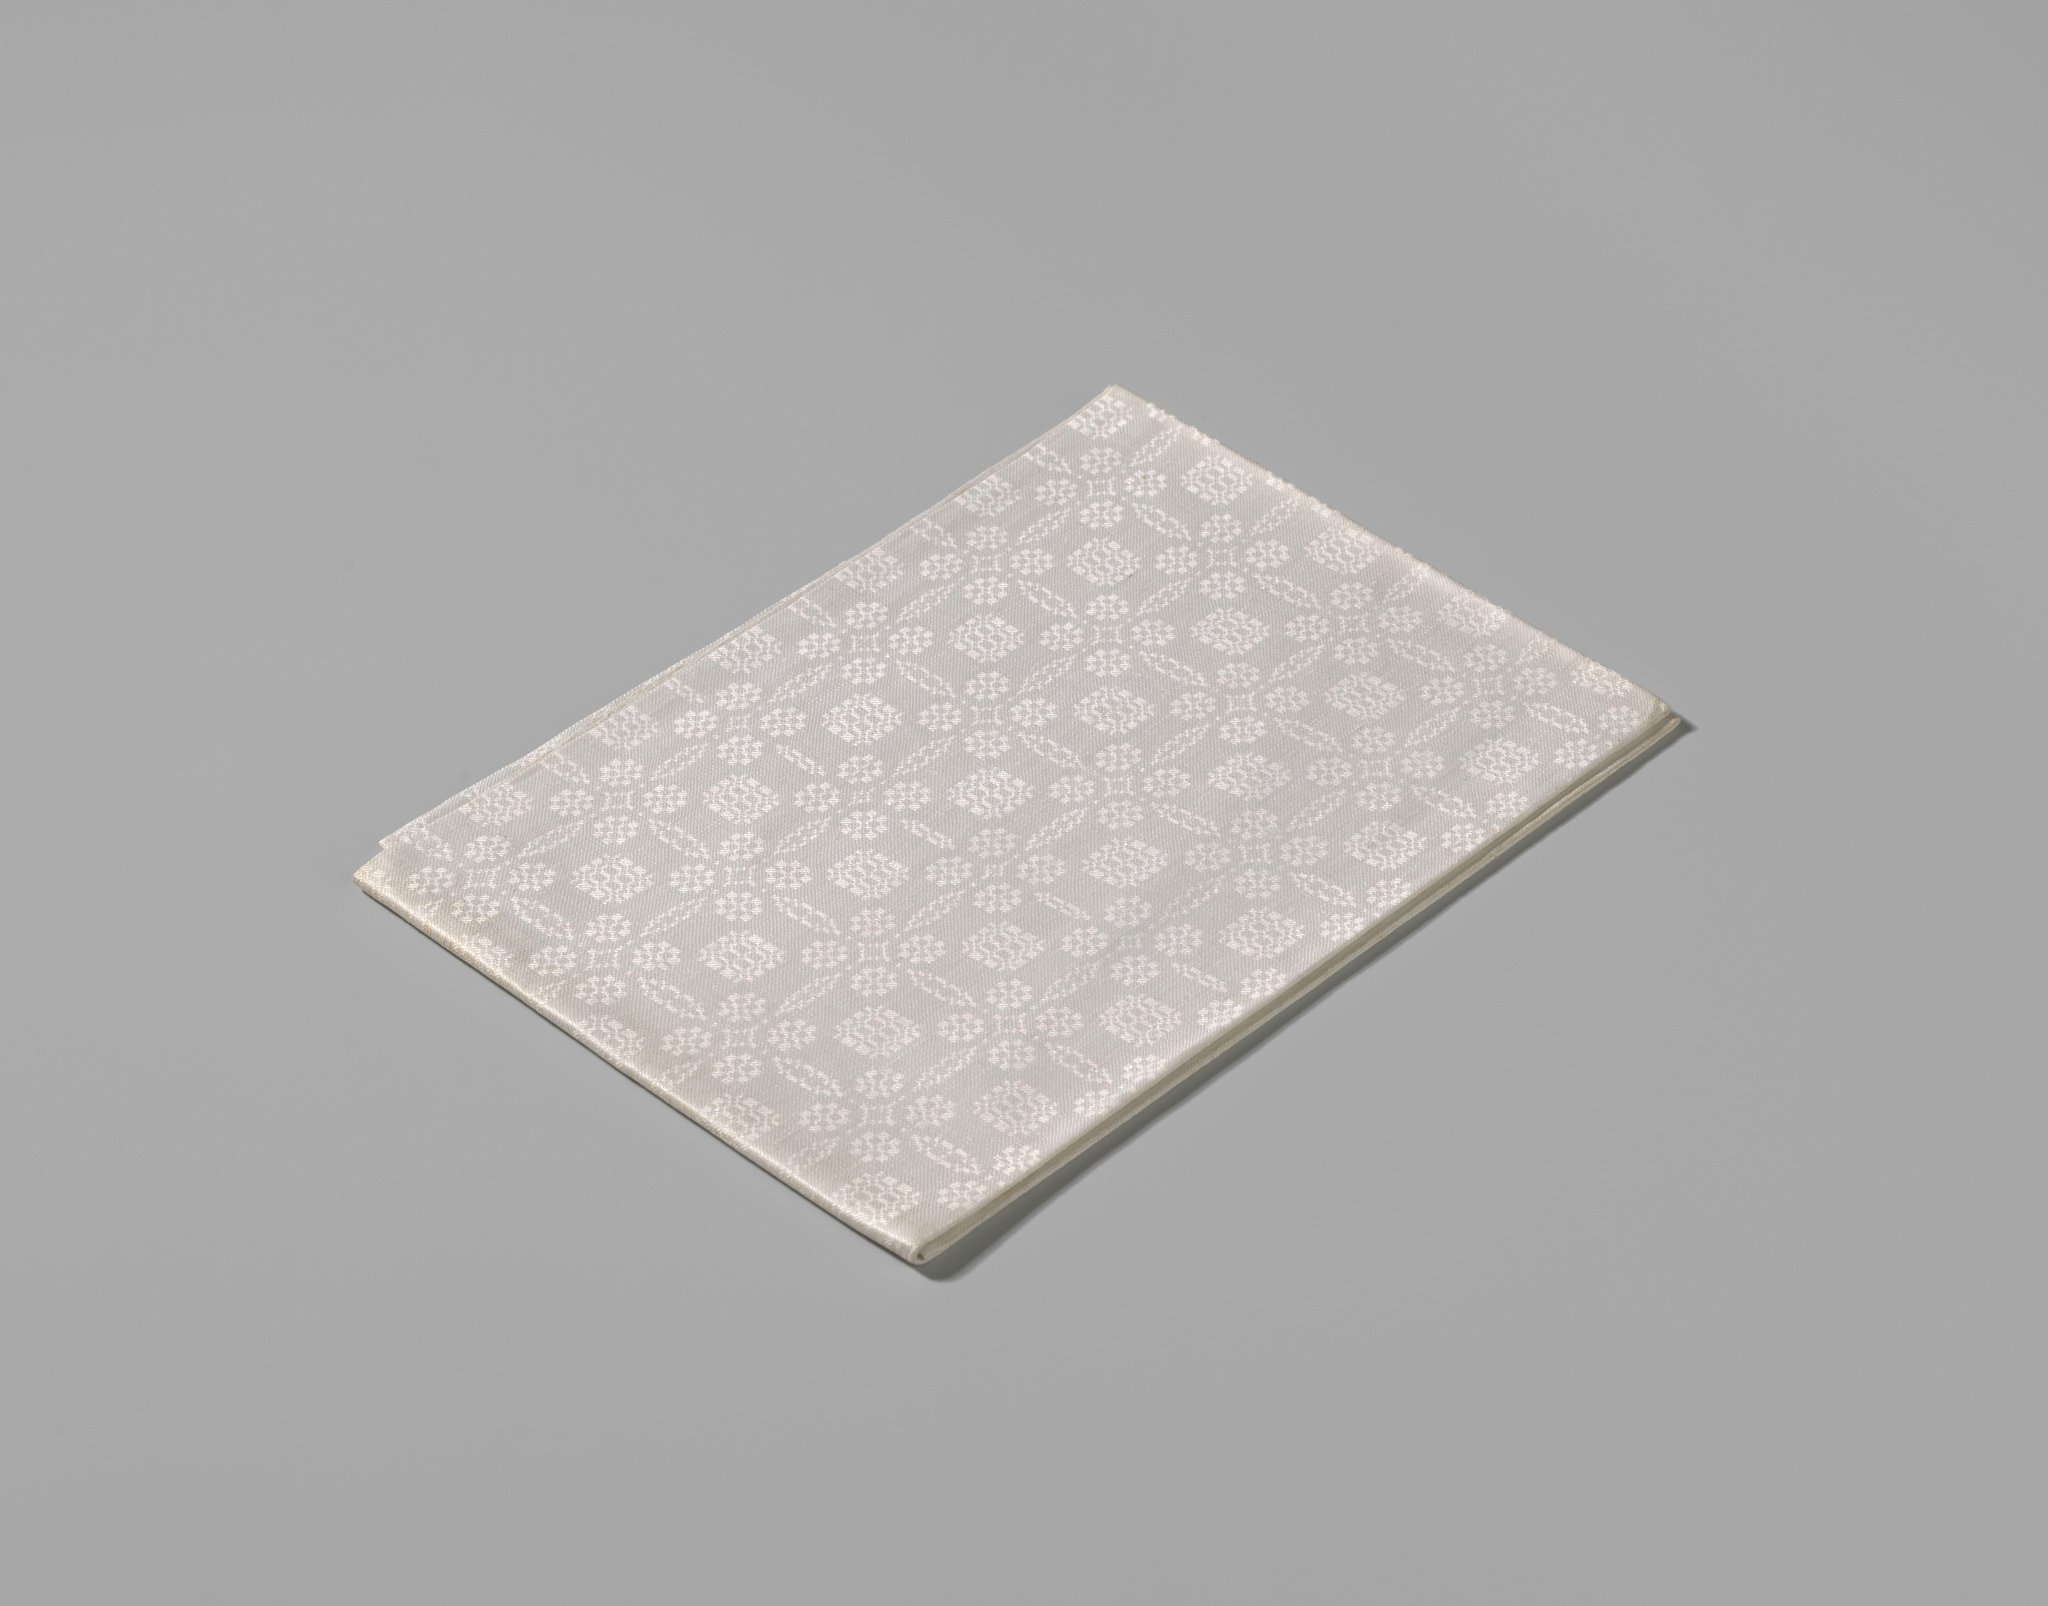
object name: napkin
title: Servet van linnen met pellenpatroon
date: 1660-1680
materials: linen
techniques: twill, peeled fabric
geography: northern netherlands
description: wit linnen servet met pellen patroon, merk kroon RR WO 40 N 6